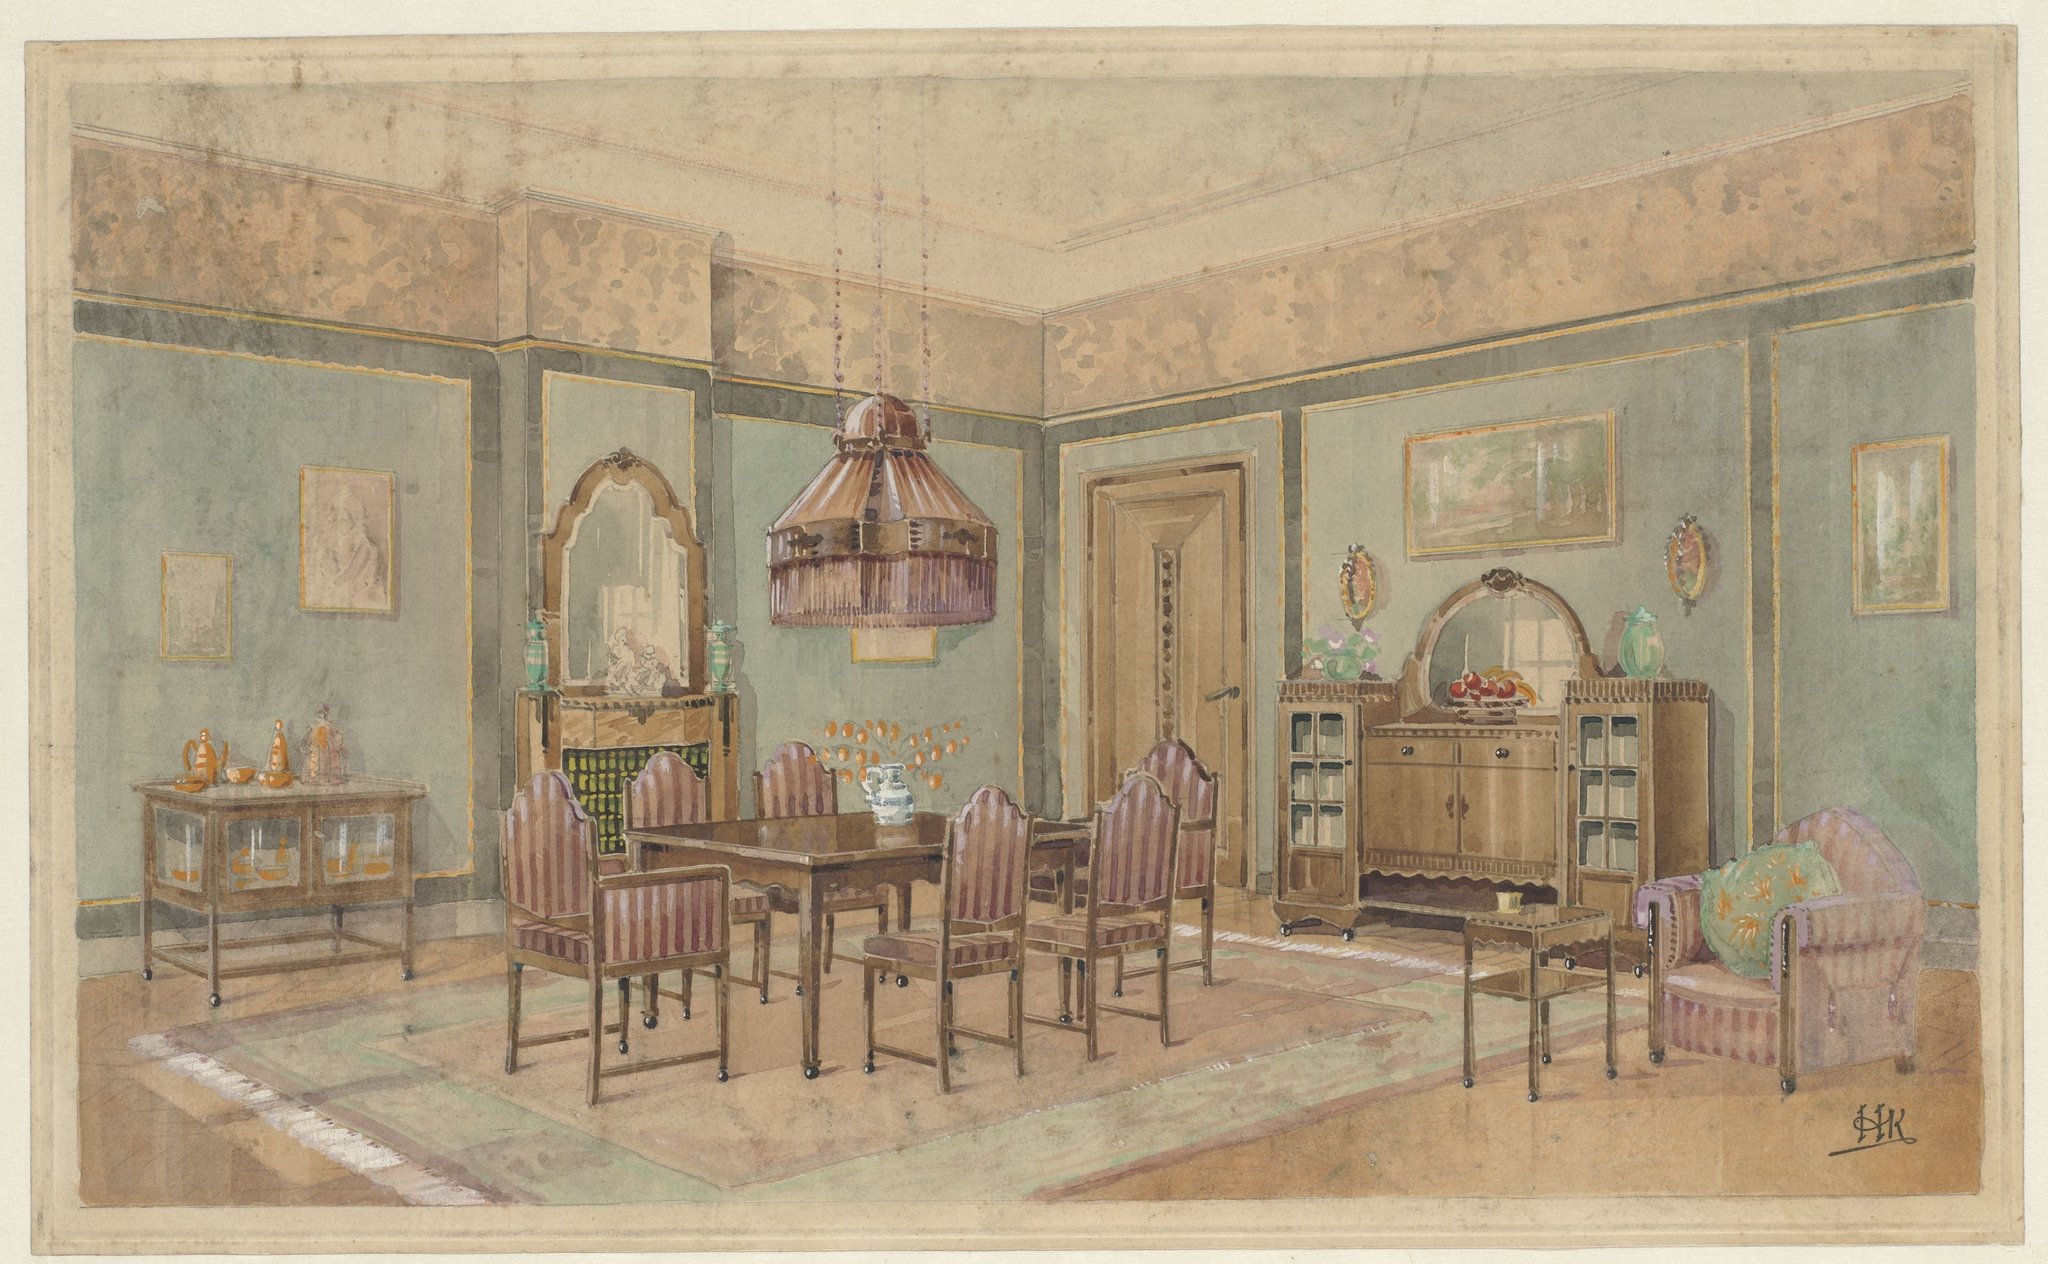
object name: watercolor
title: Eetkamer met kastje met oranje servies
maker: monogrammist hk (nederland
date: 1925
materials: paper, watercolor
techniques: brush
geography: amsterdam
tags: dining-room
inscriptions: monogram: ‘HK’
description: Mogelijk is dit een demonstratietekeningen van een meubel- of inrichtingszaak.